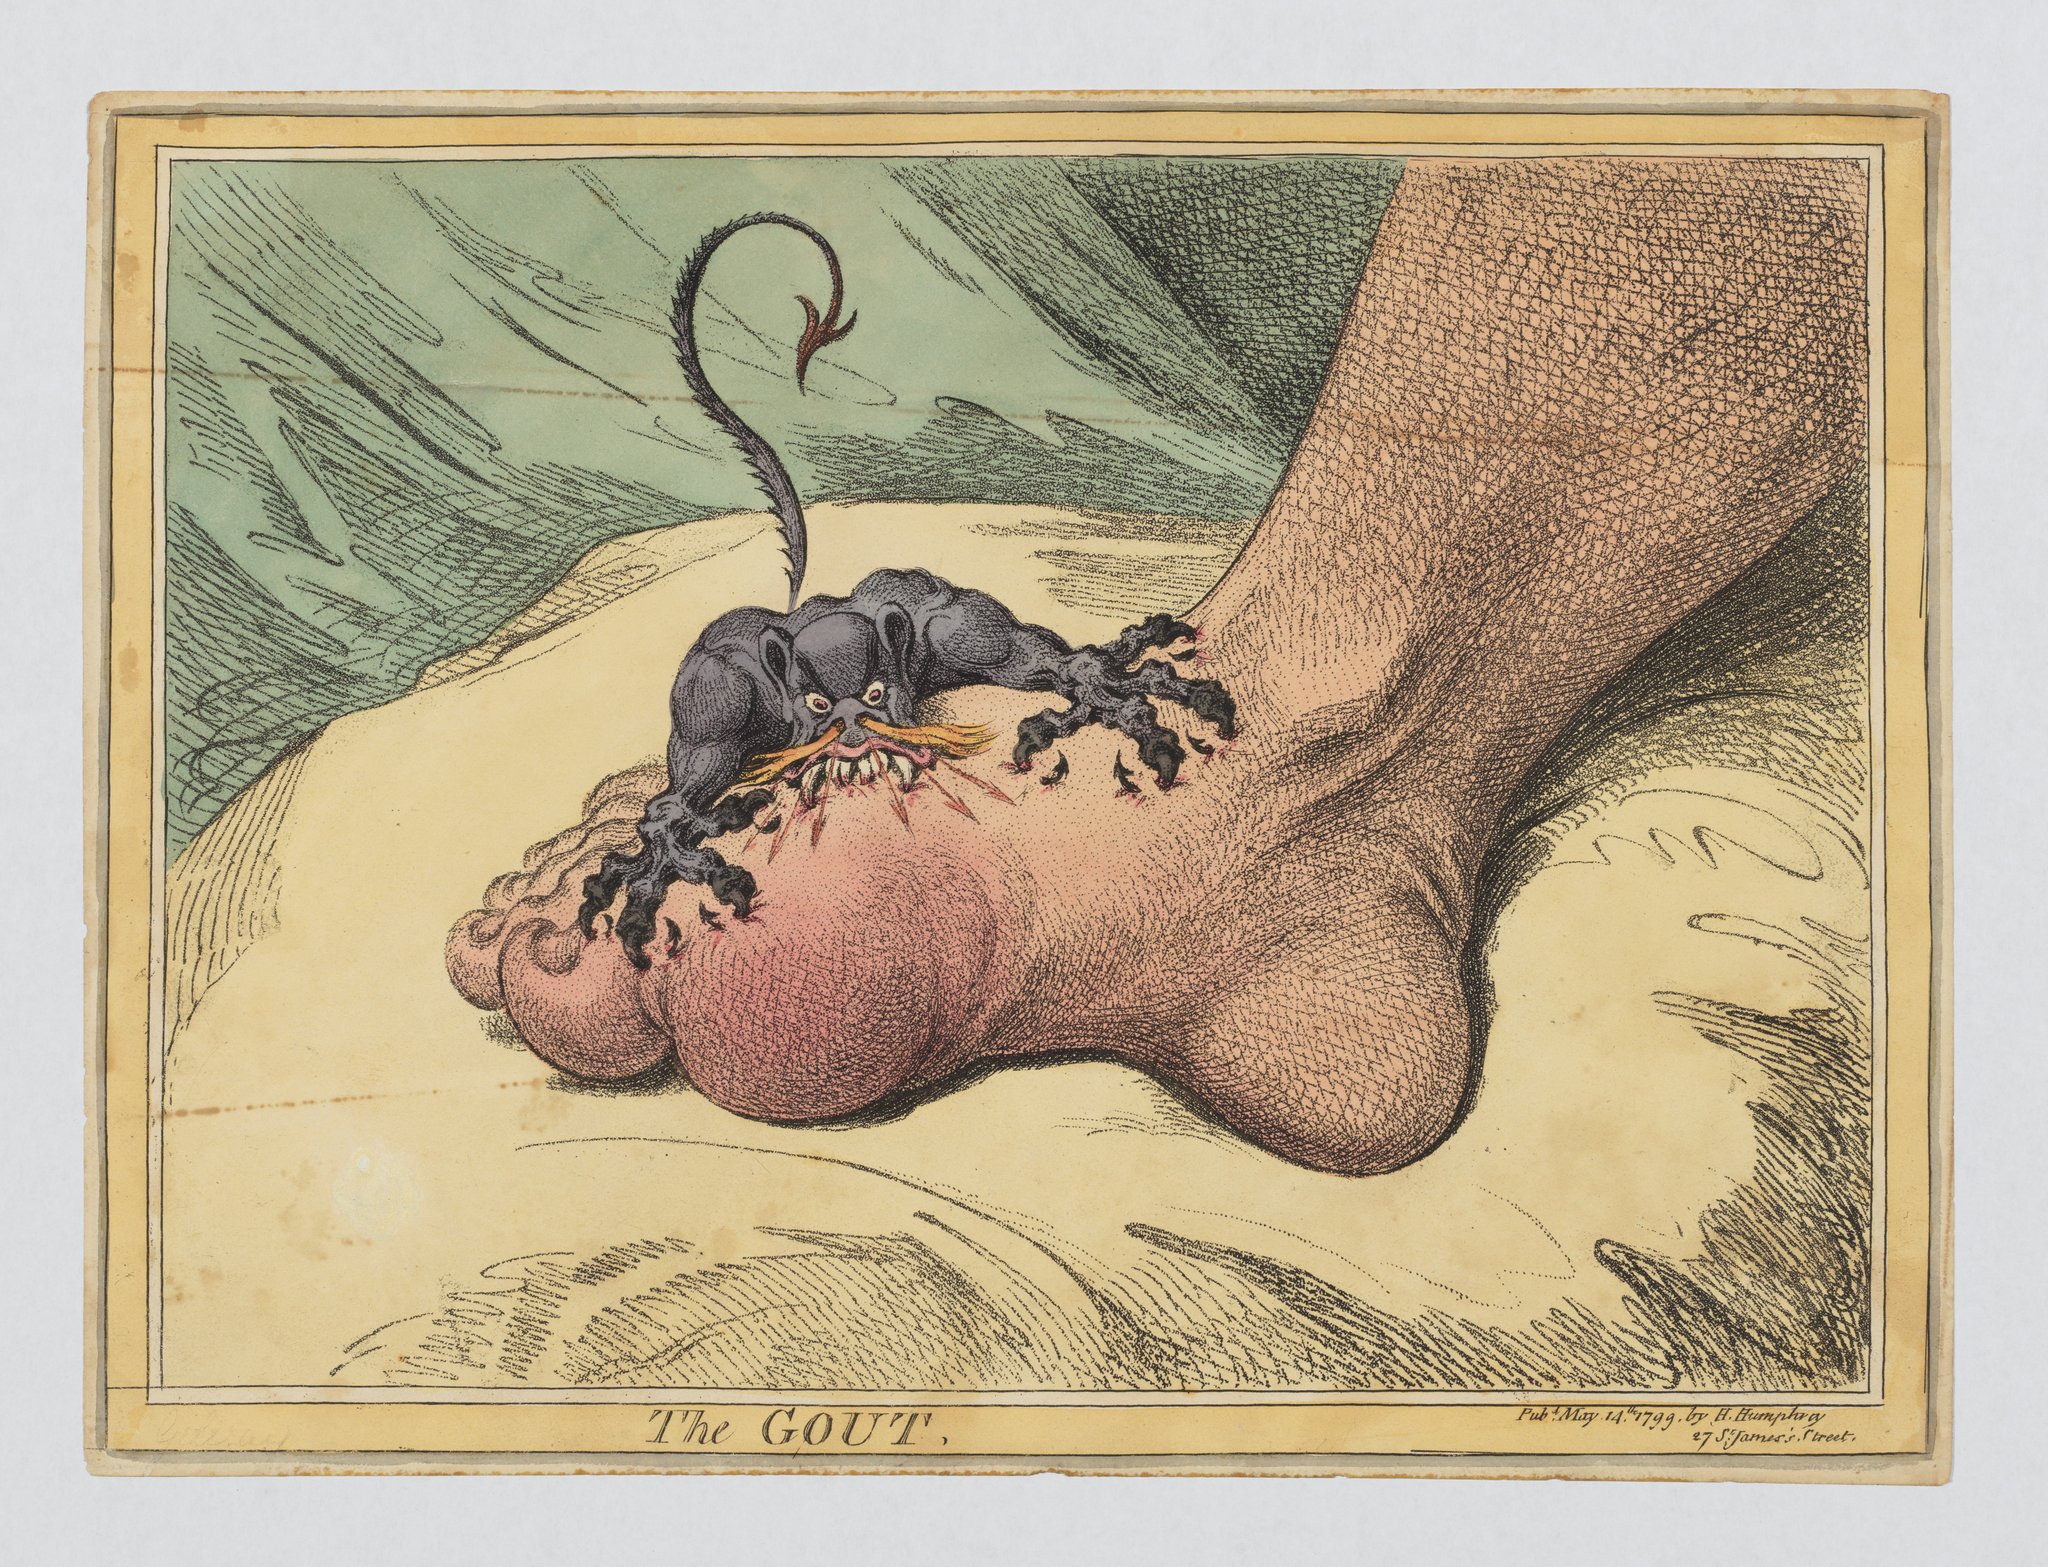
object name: print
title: The Gout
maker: james gillray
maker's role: artist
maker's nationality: british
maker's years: 1756-1815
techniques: hand coloring, etching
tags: satire,feet,demons